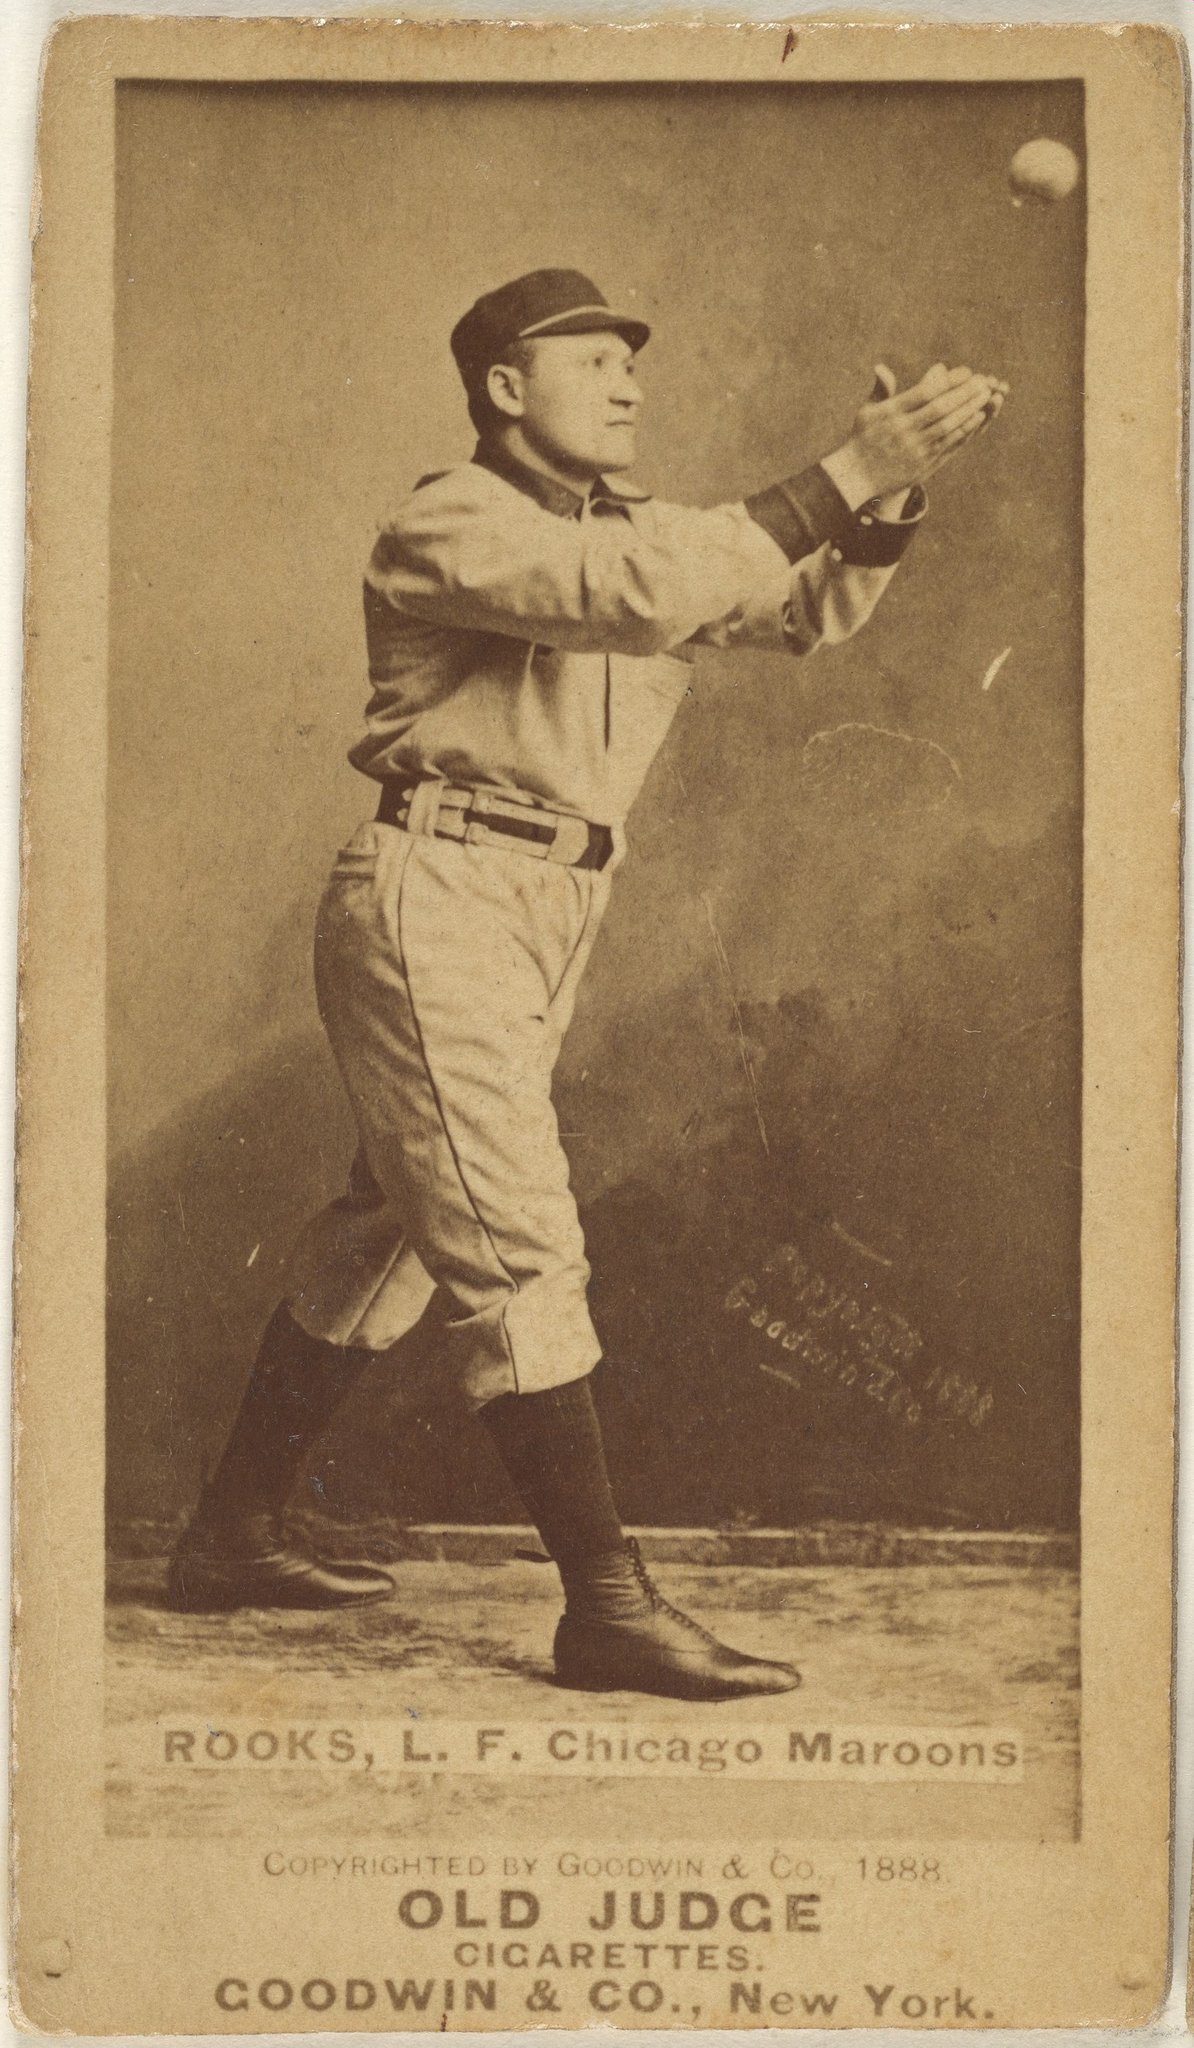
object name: baseball card, photograph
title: Rooks, Left Field, Chicago, from the Old Judge series (N172) for Old Judge Cigarettes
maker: goodwin & company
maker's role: publisher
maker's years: 1850-1950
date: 1888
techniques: albumen silver print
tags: men,portraits,baseball,athletes